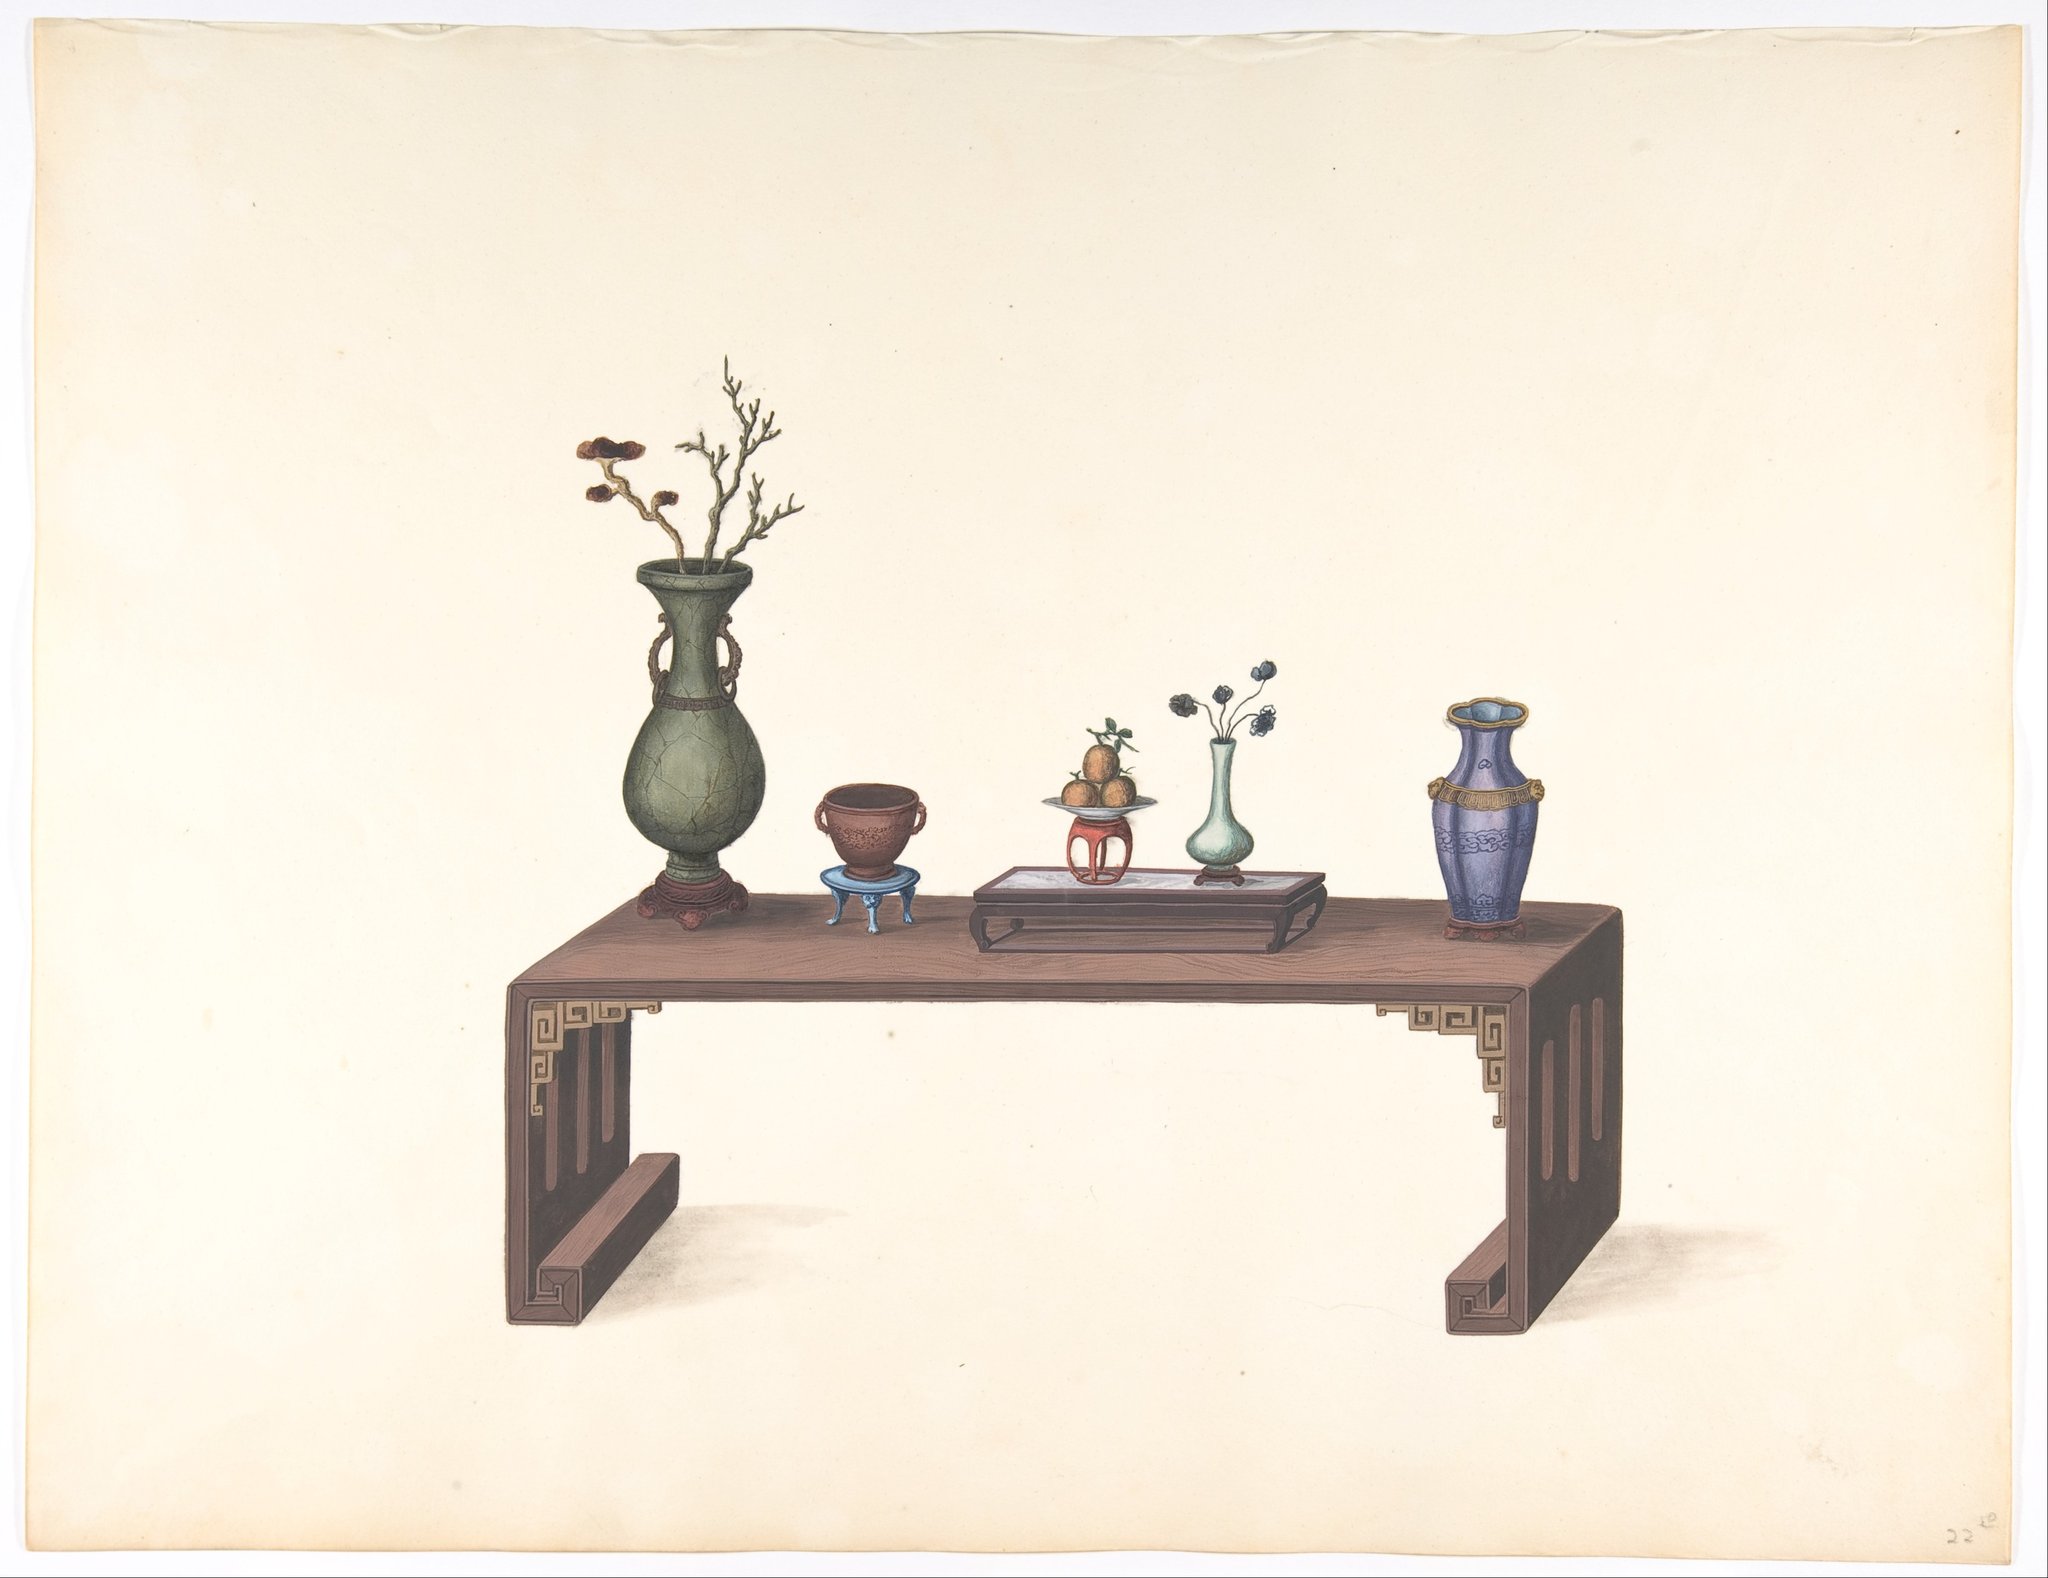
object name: drawing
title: Low Table with Vases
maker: anonymous, chinese, 19th century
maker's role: artist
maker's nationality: chinese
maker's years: 1800-1900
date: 1801-1900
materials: gouache, ink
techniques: pen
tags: tables,vases